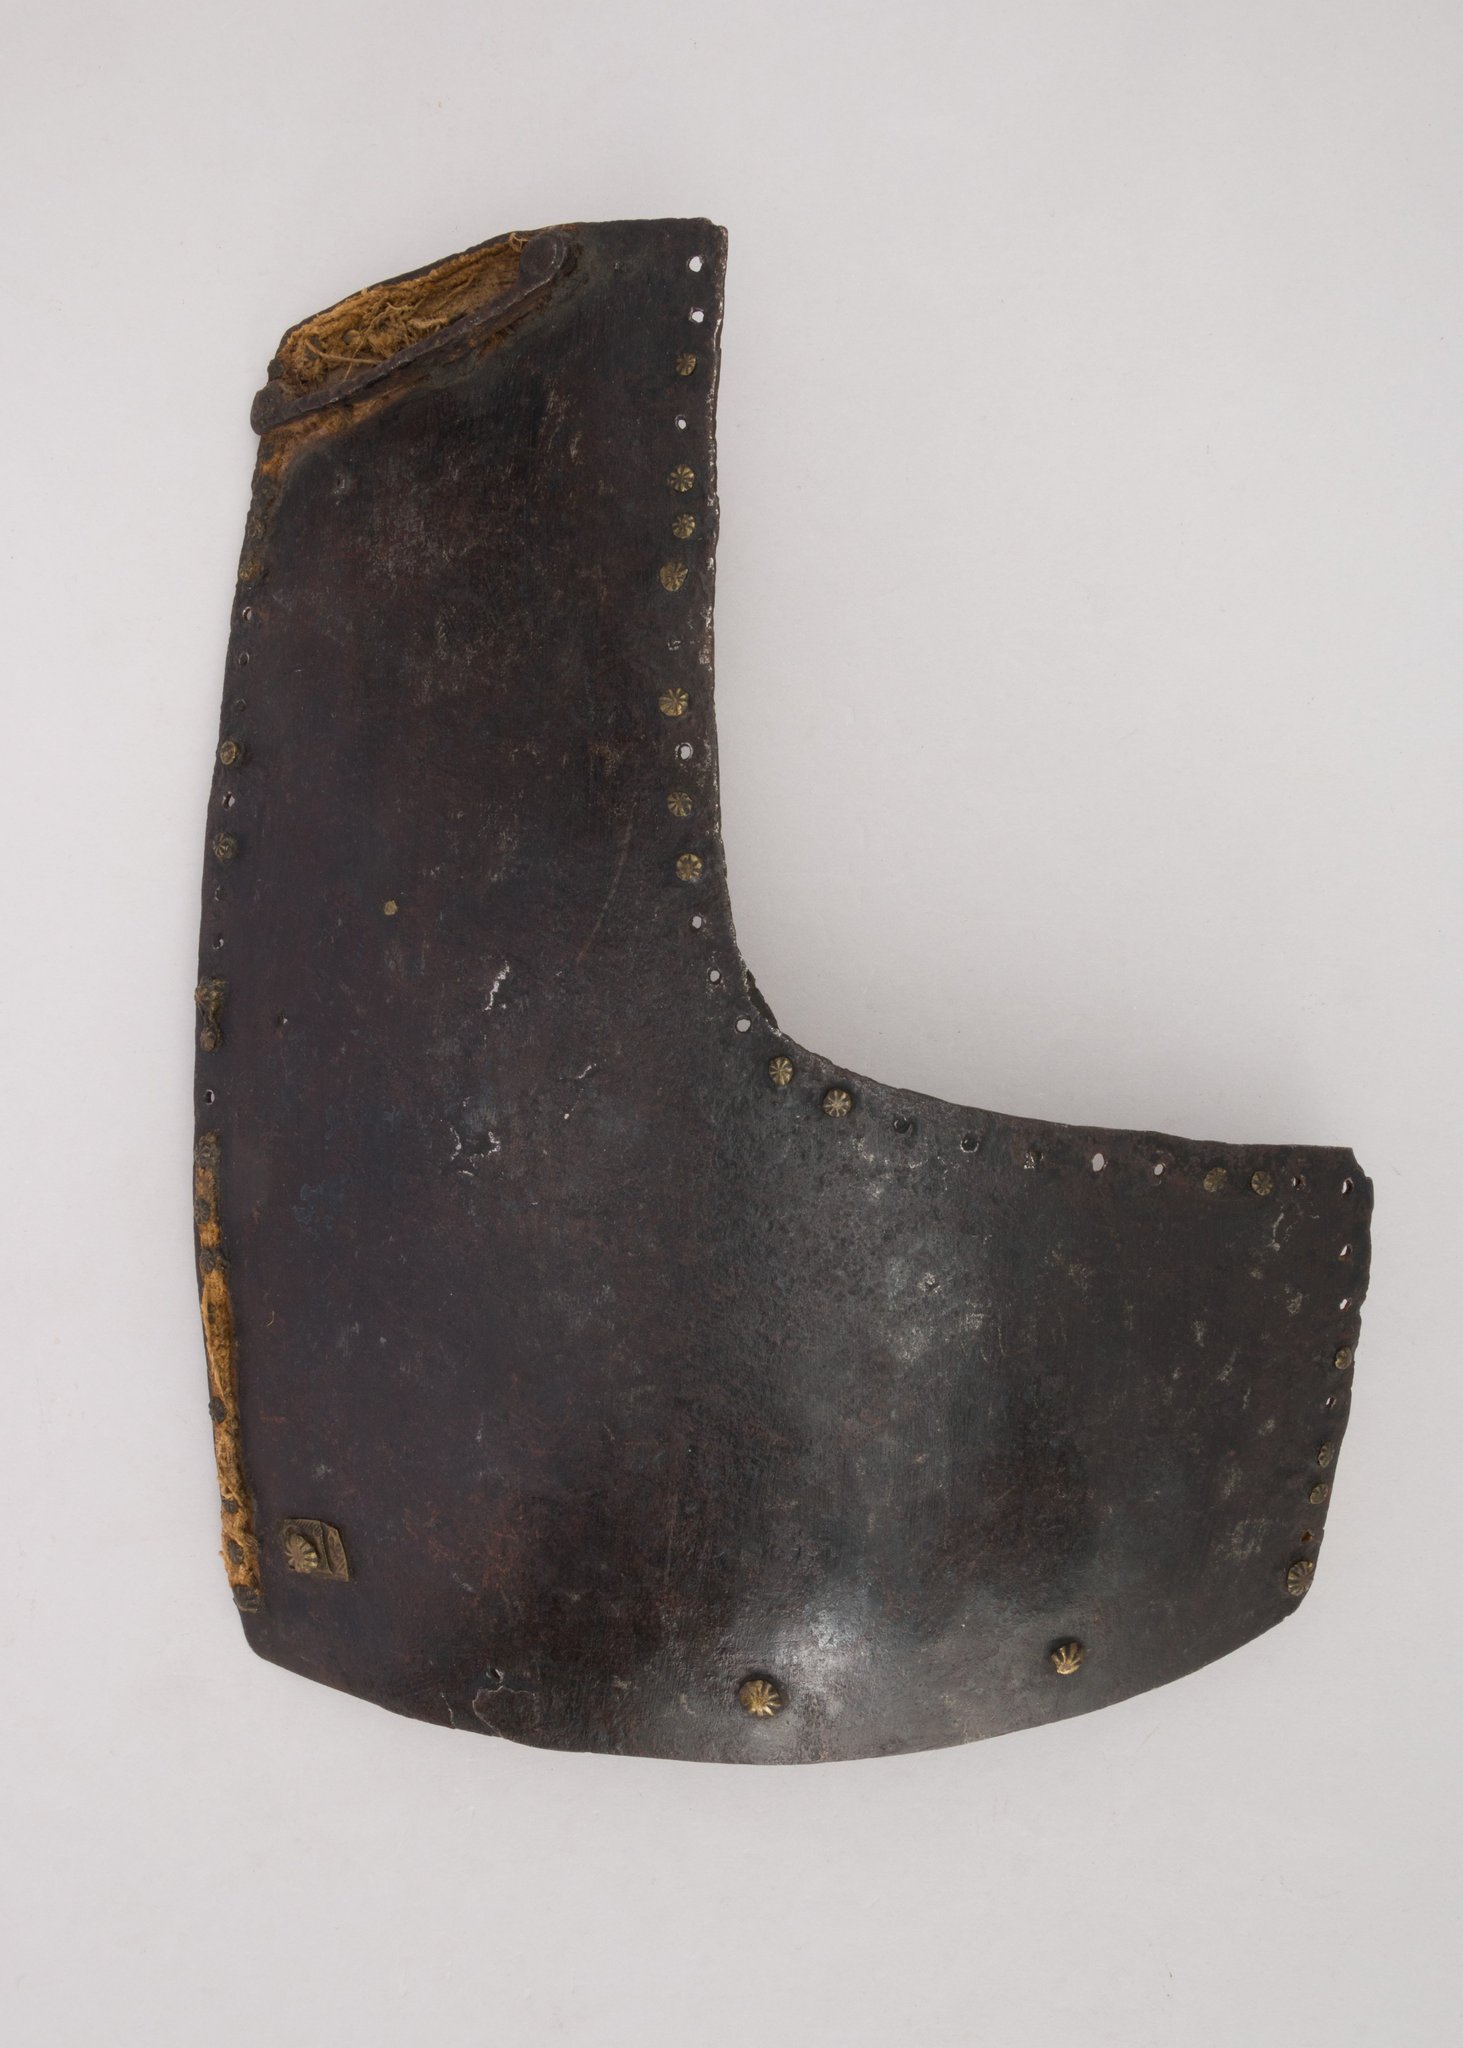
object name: left half of a breastplate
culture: italian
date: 1400-1450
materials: copper alloy, steel, textile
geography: italy